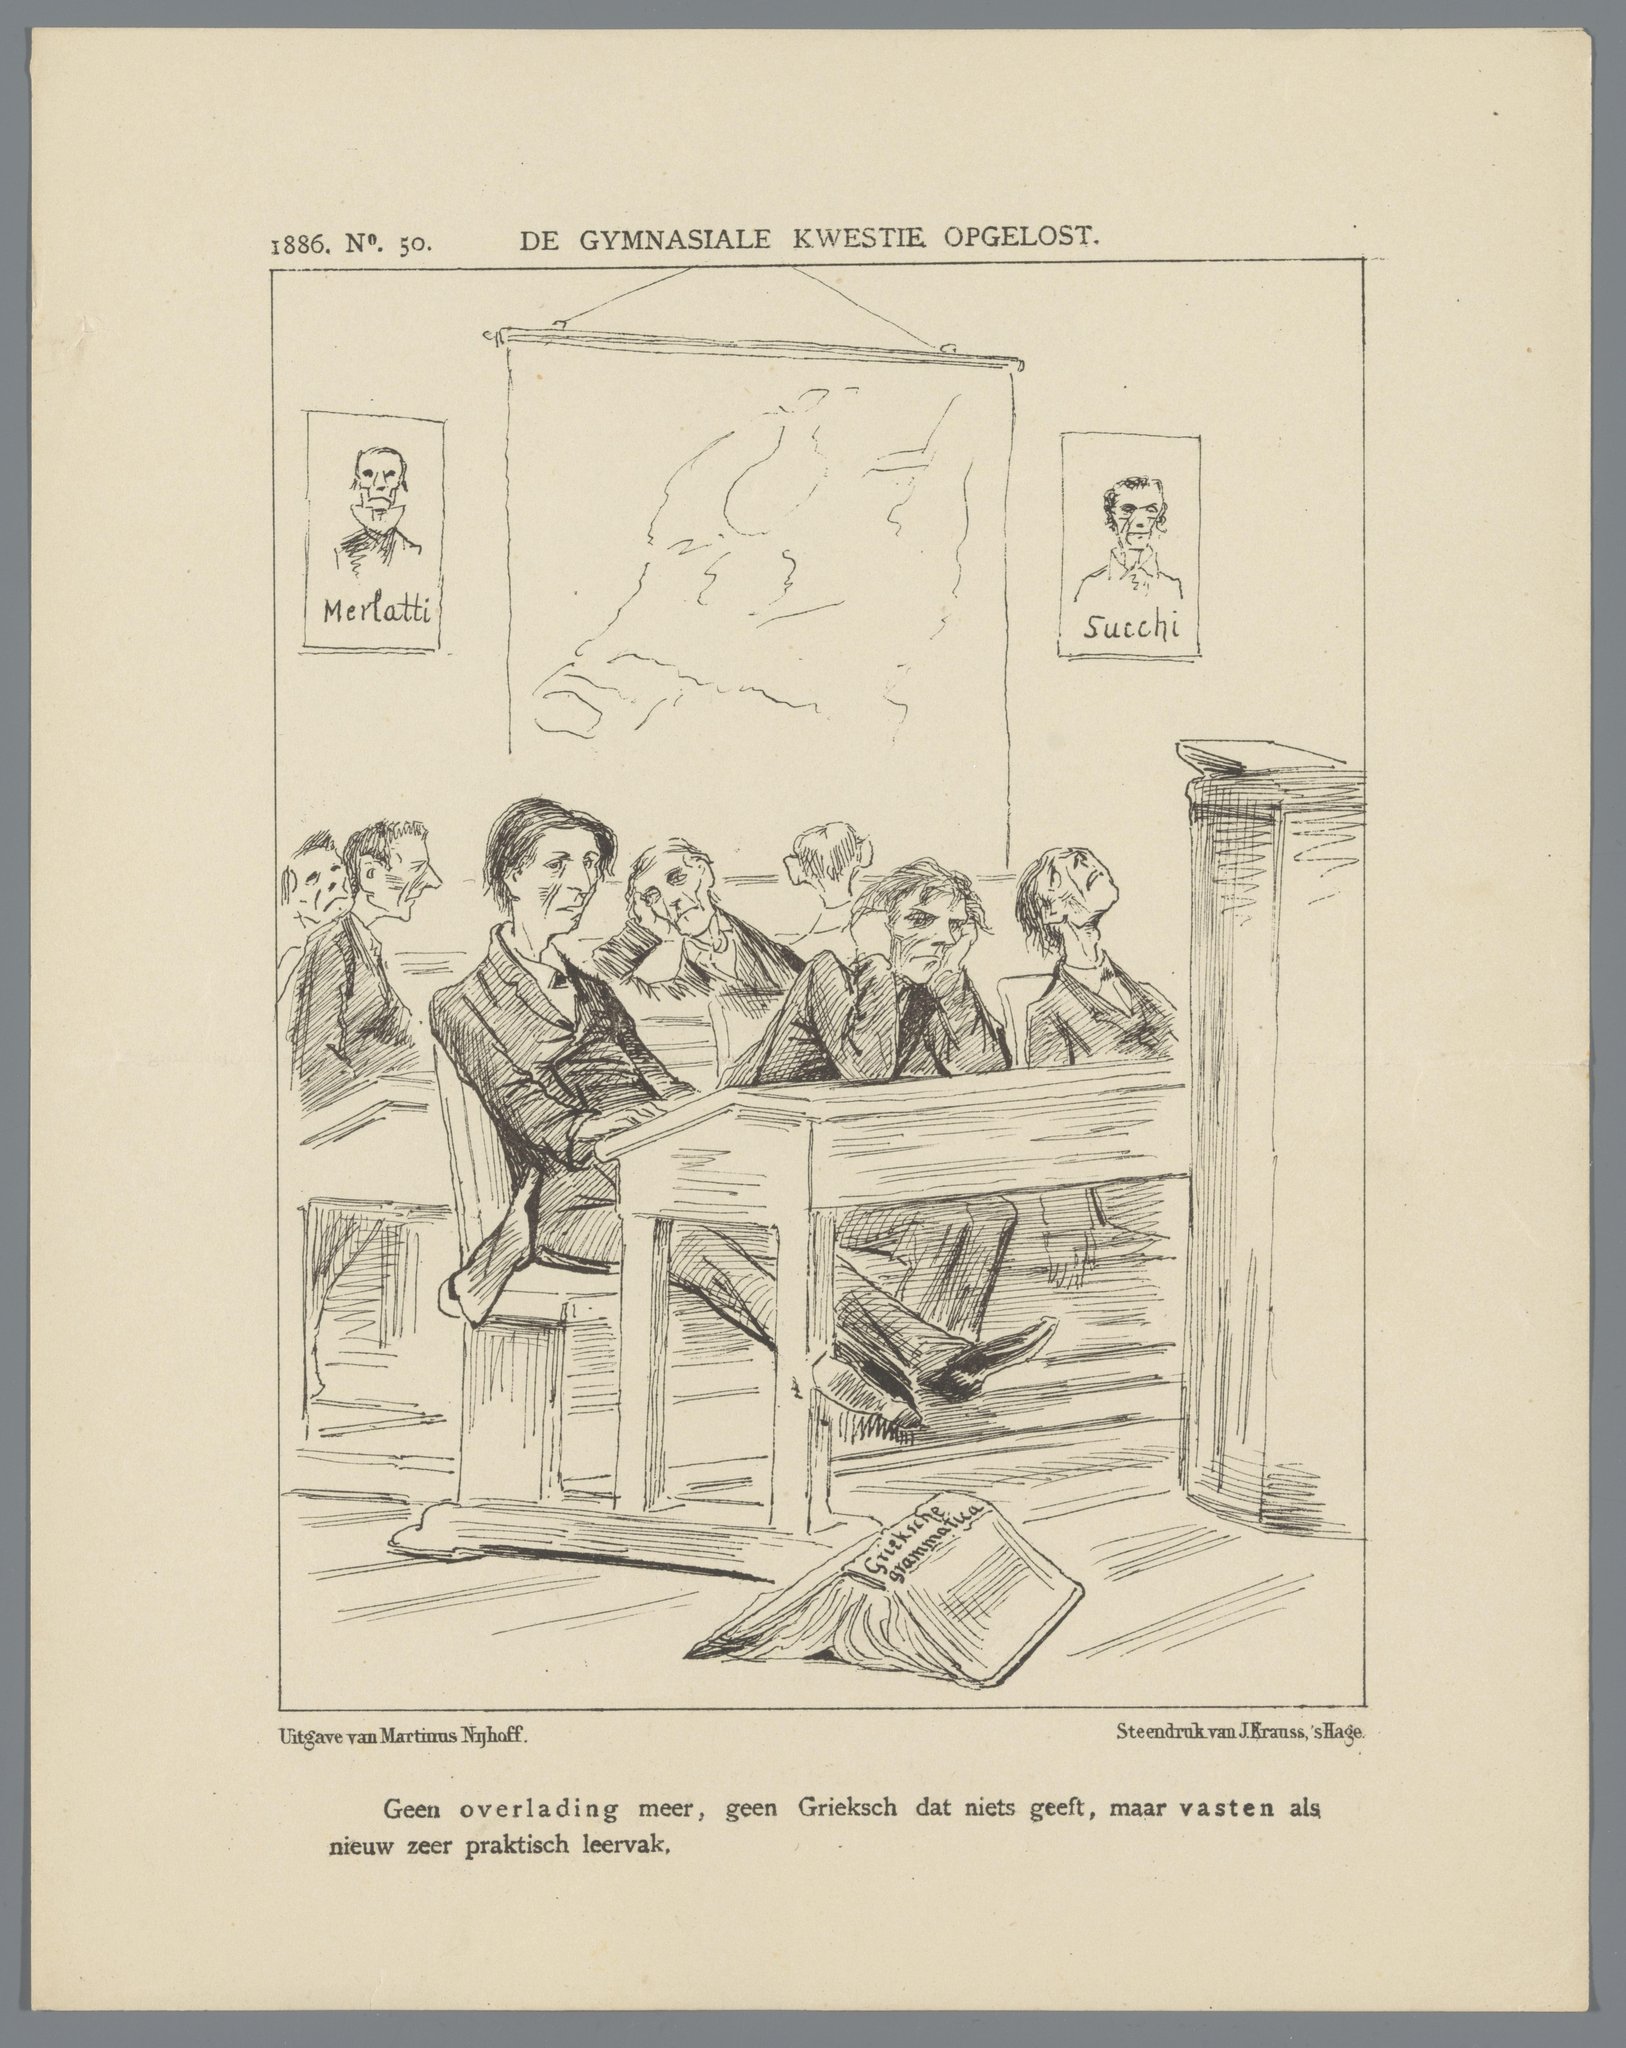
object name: cartoon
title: Spotprent over gymnasia, 1886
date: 1886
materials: paper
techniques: lithograph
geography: netherlands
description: Spotprent over de gymnasiale kwestie. Plaat verschenen bij het weekblad De Nederlandsche Spectator, nr. 50, 1886.